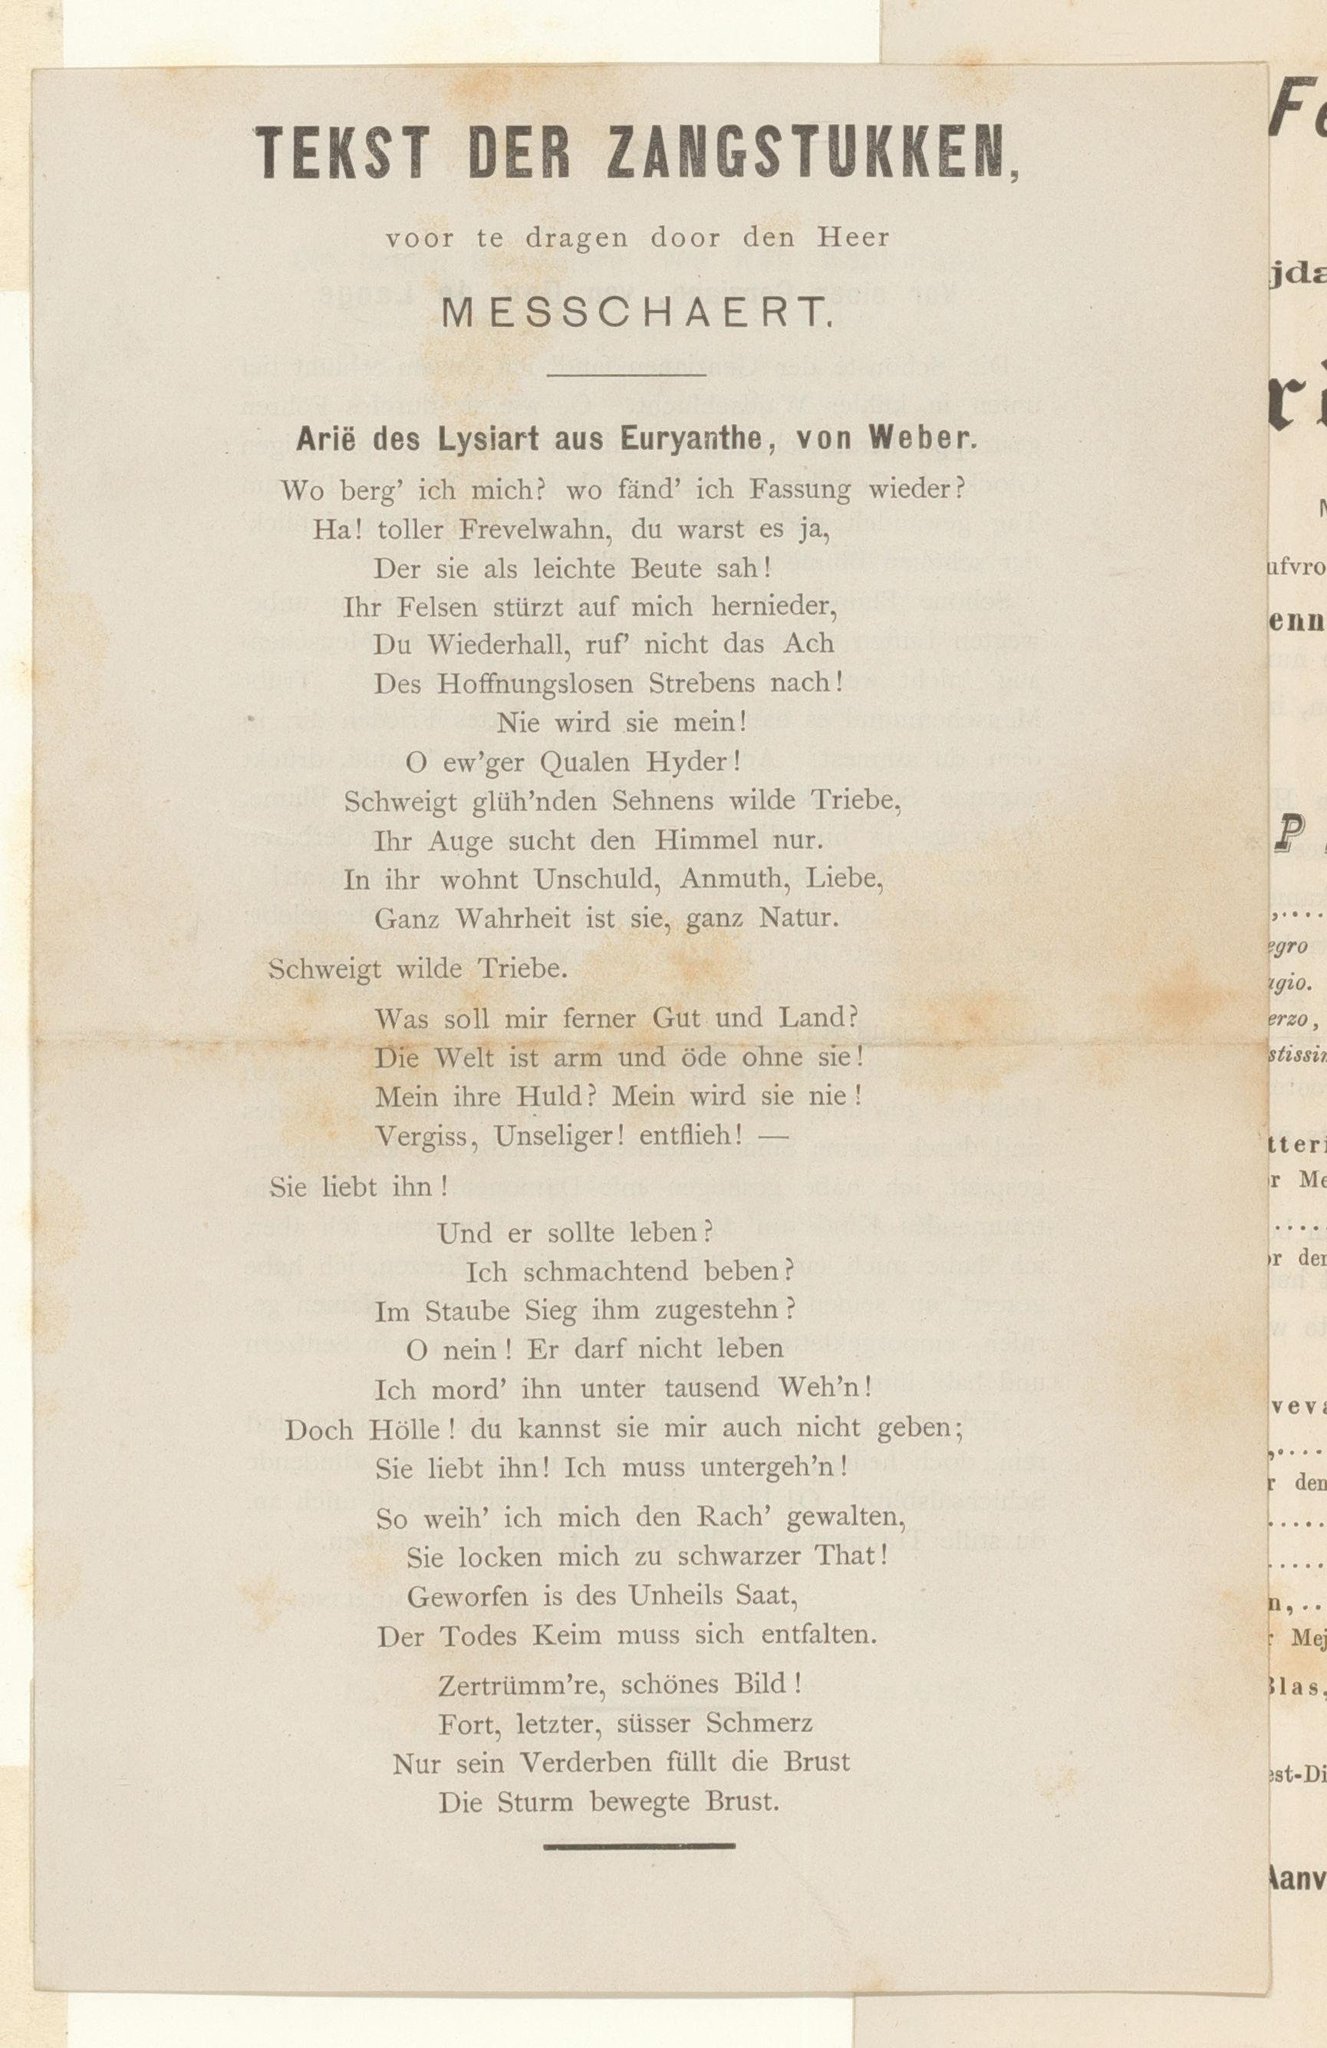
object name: programma, programmaboekje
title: Tekst van de zangstukken bij het programma voor een concert in Felix Meritis op 8 december 1882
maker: Anonymous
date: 1882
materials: paper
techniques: letterpress printing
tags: the hague, johannes verhulst, listening to music, large group of musicians, orchestra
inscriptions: collector's mark, collector's mark: Lugt 1641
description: Gedrukte tekst van de zangstukken, behorende bij het programma voor het Tweede Concert door het orkest onder leiding van Johannes Verhulst, in Felix Meritis te Amsterdam op 8 december 1882. Onderwerpsrubrieken binnen de Atlas Zeden en Gewoonten: Muziek en muziekinstrumenten: Varia.